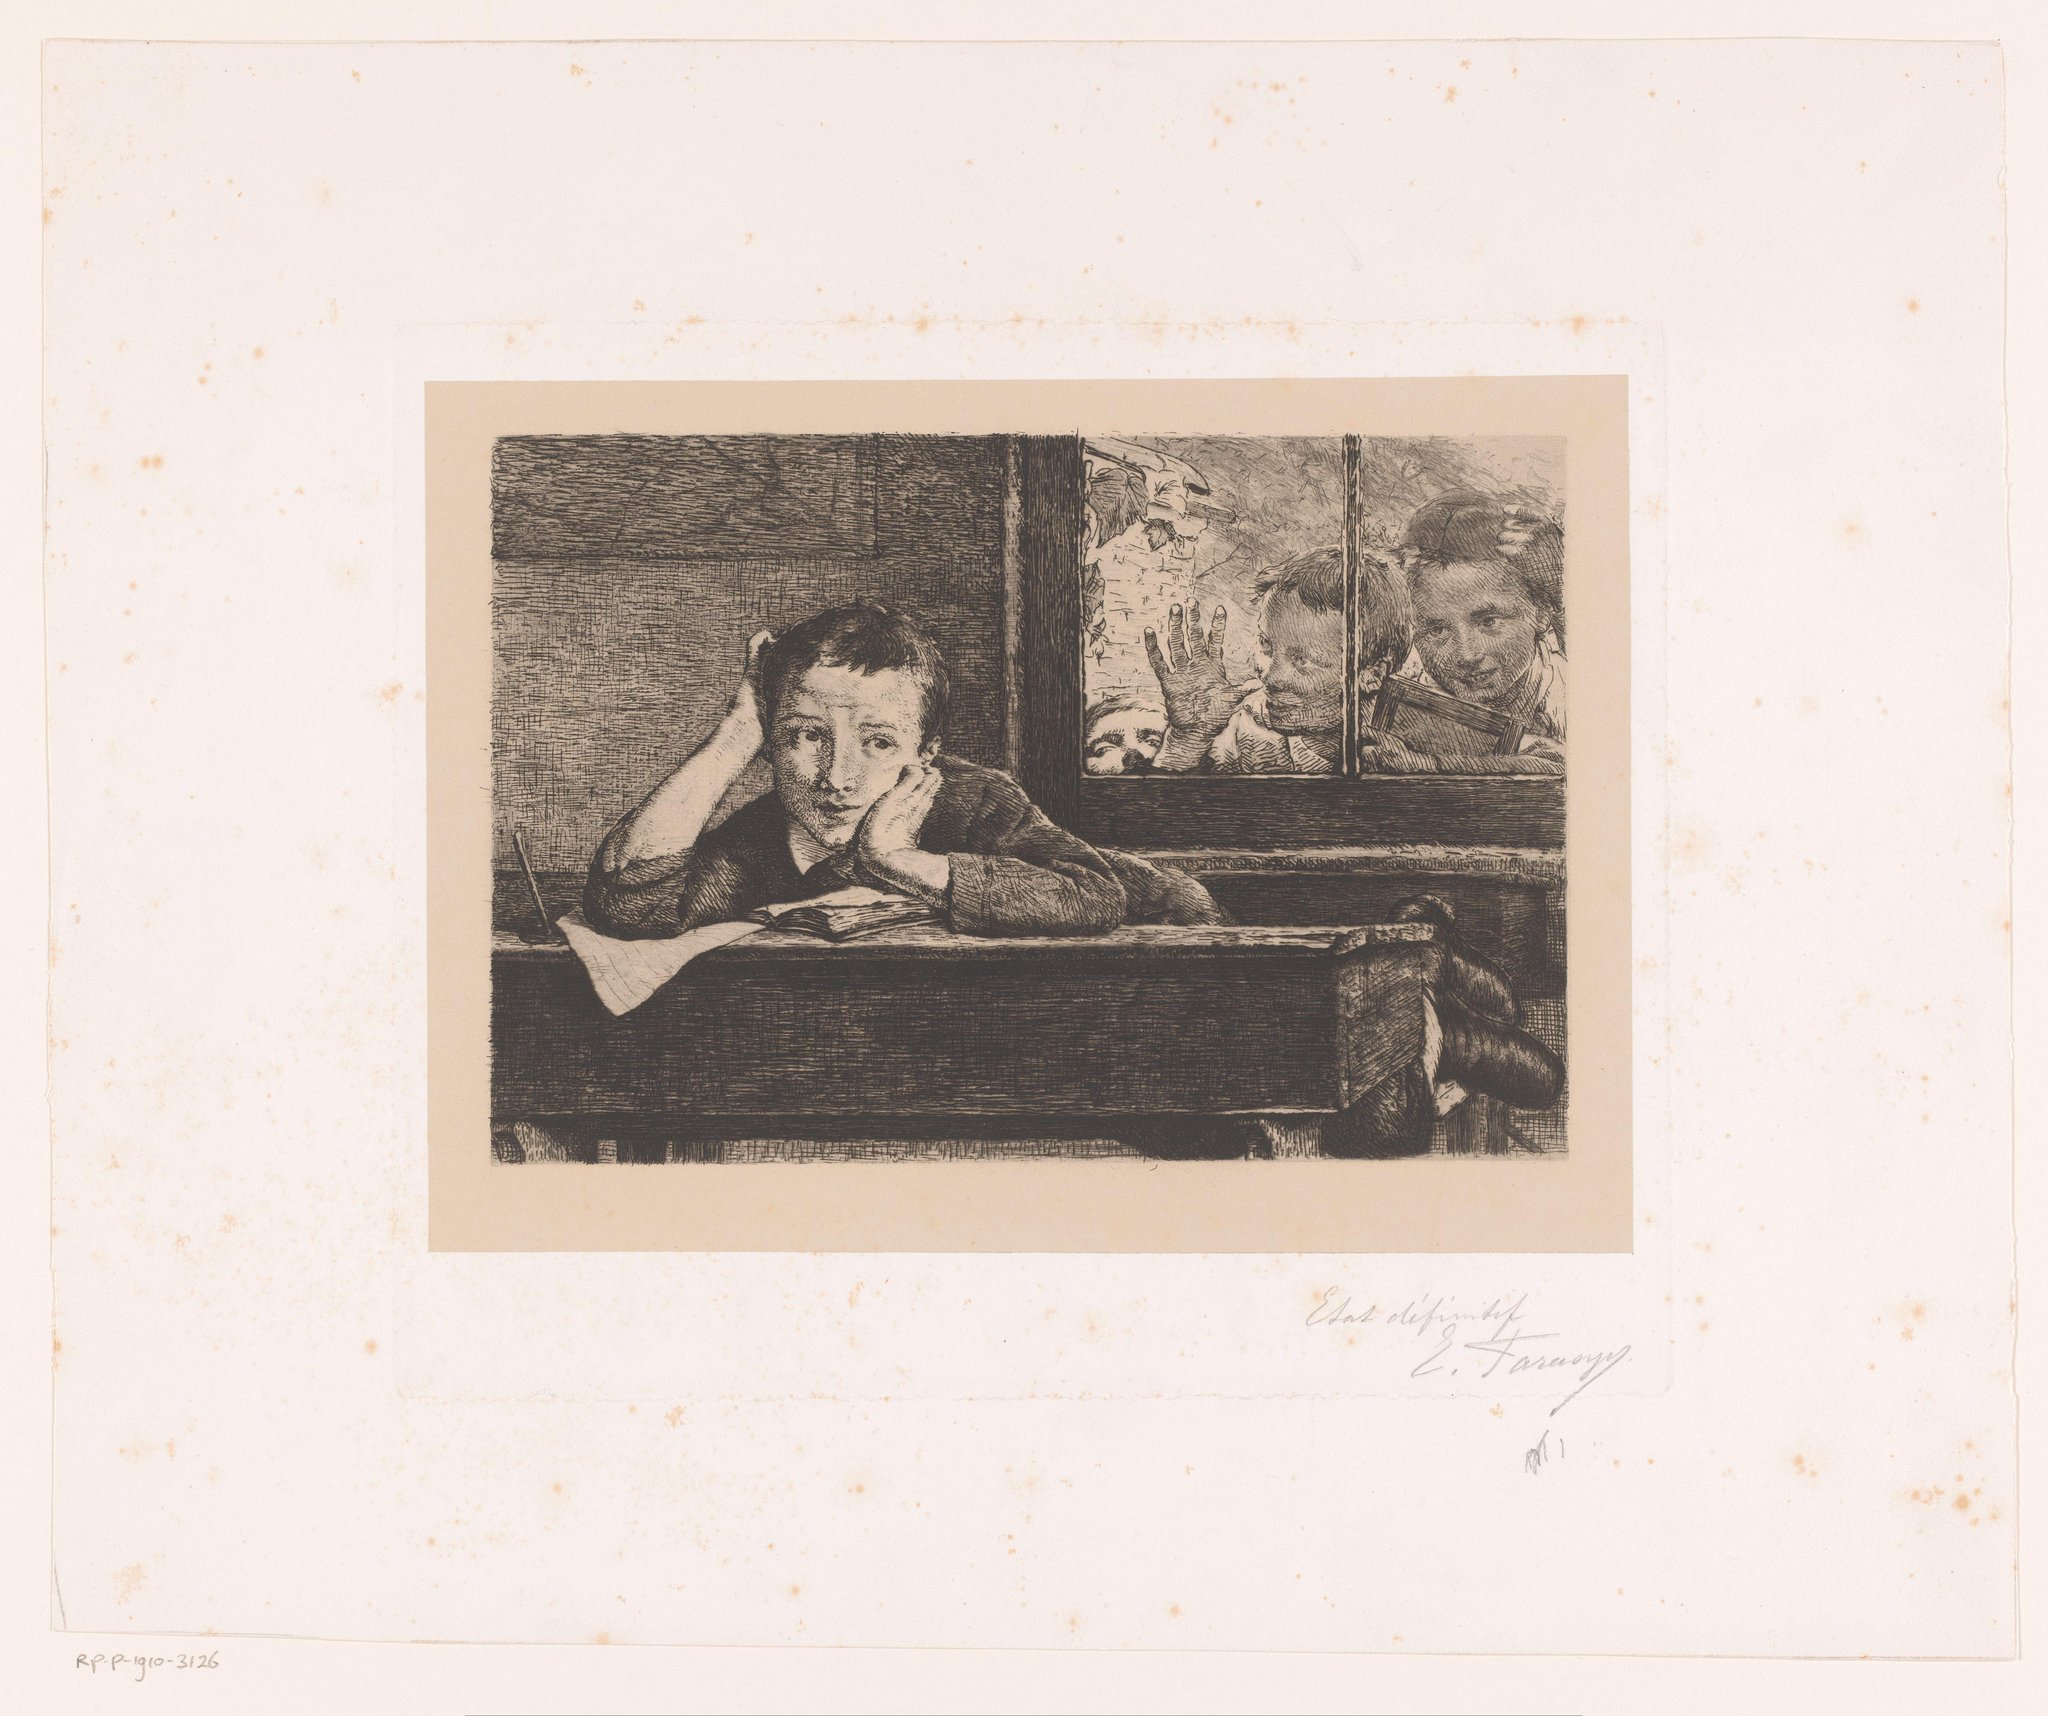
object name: print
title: Drie kinderen kijken door een raam naar een jongen die over een schoolbank hangt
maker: edgard farasyn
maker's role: print maker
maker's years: 1858-1938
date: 1868-1910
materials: paper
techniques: etching, intaglio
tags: writing-table, writing-desk, child (+ four persons), closed window, elementary school; class, form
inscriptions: collector's mark: Lugt 2228, inscription: ‘Etat définitif’